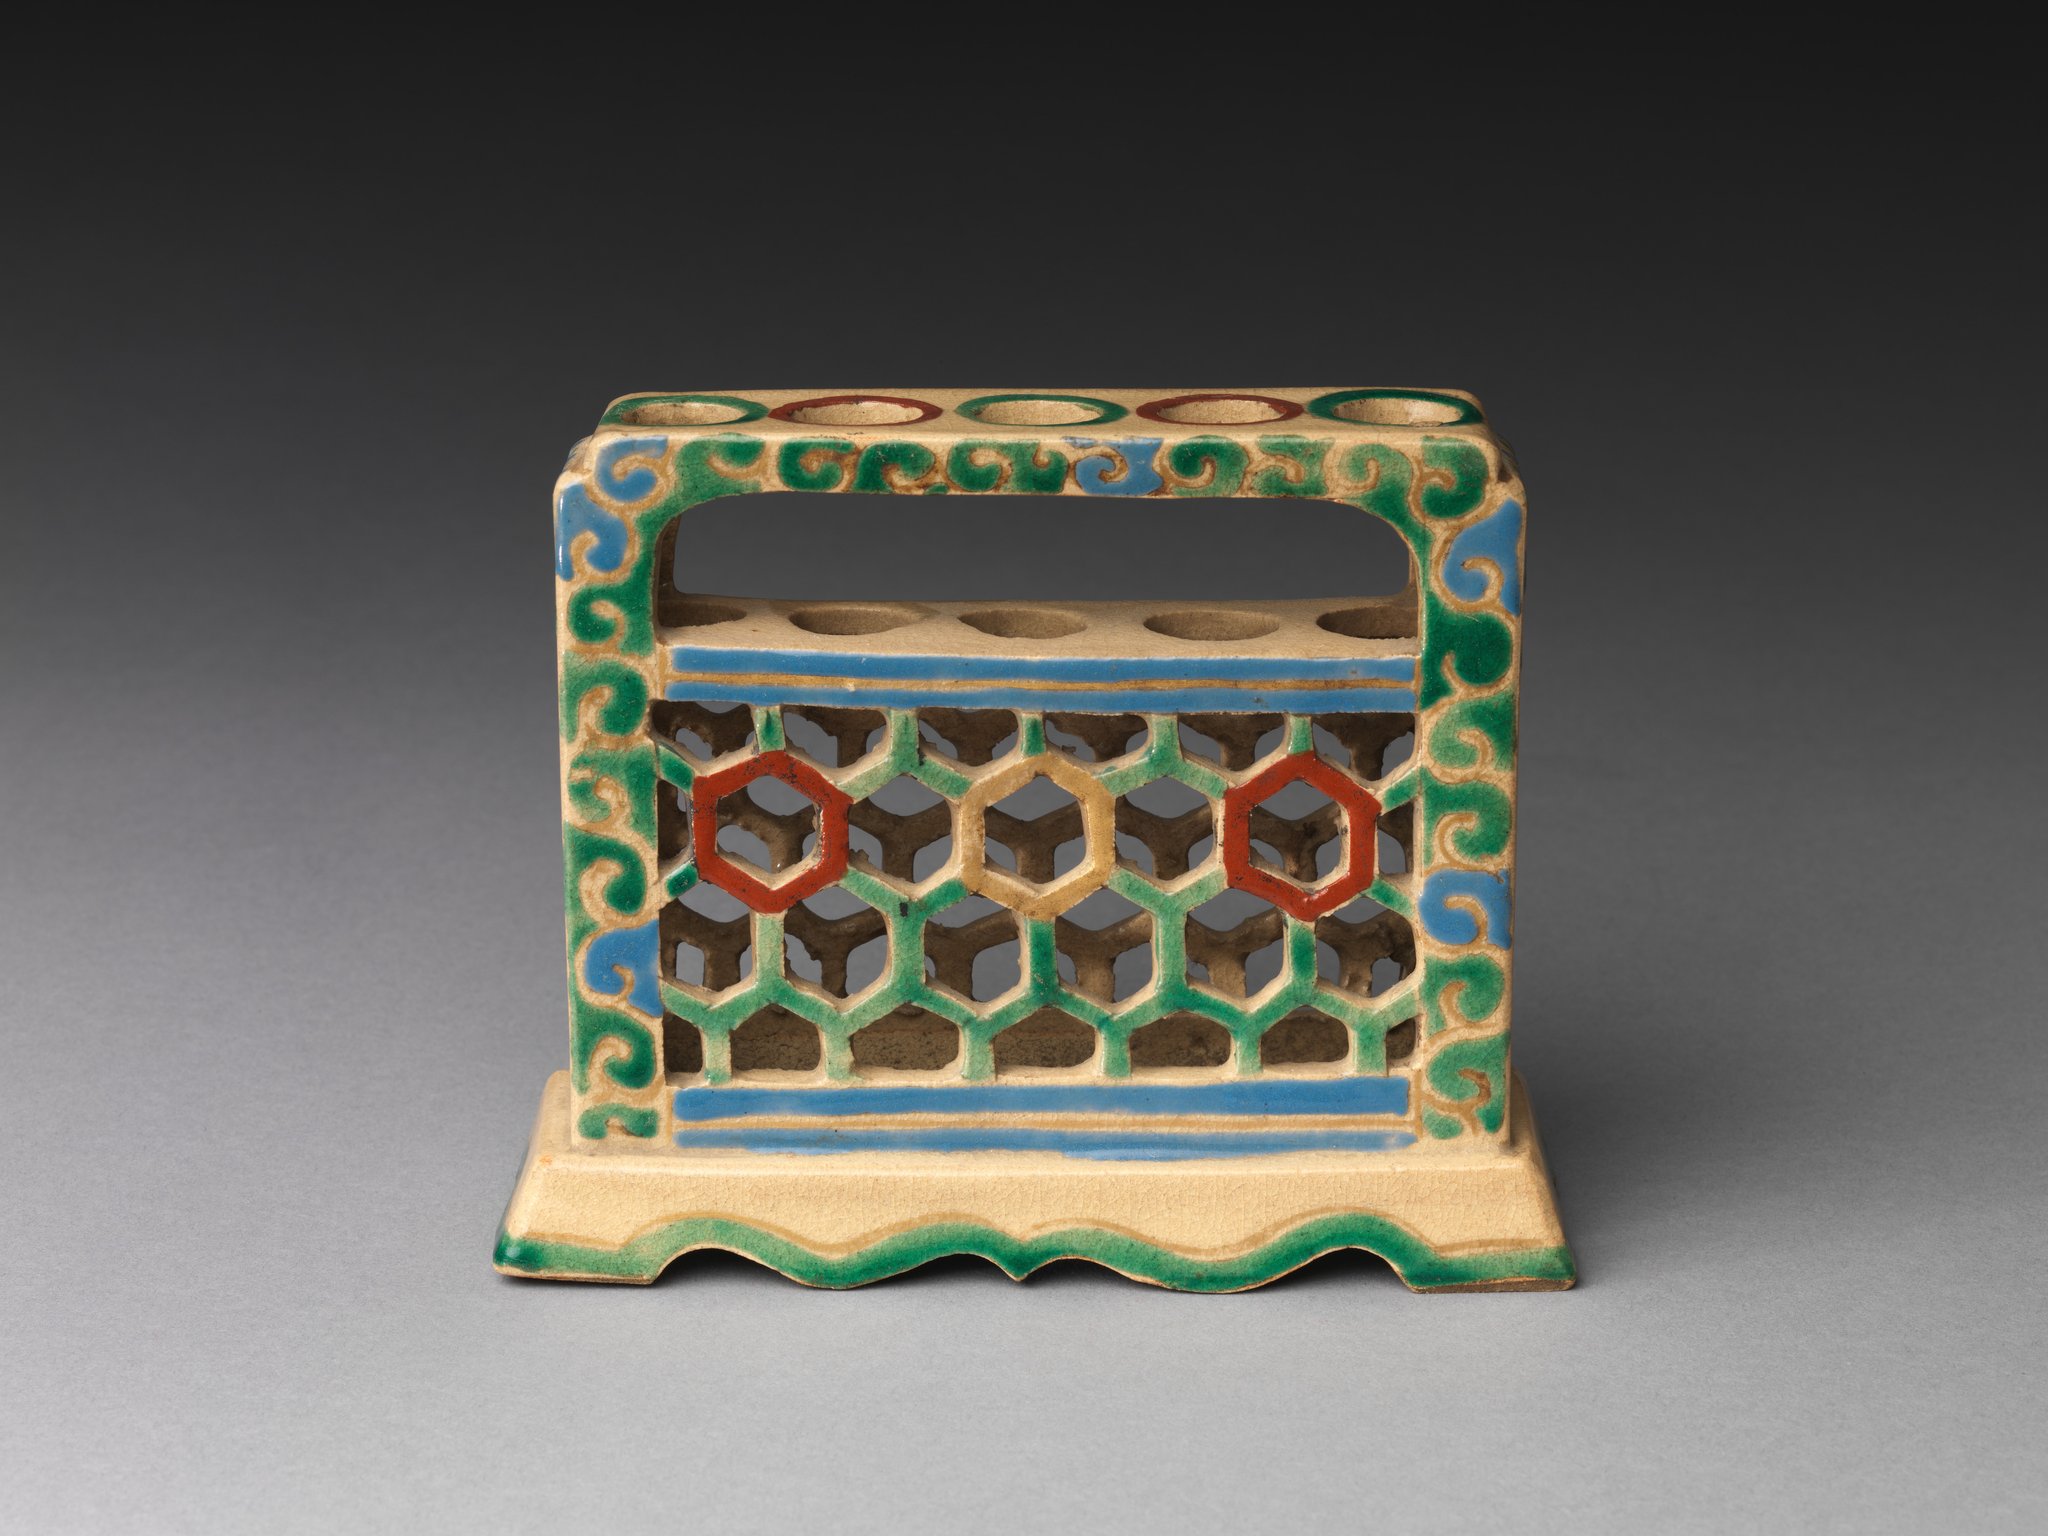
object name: brush holder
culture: japanese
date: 1701-1800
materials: enamel, stoneware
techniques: polychrome